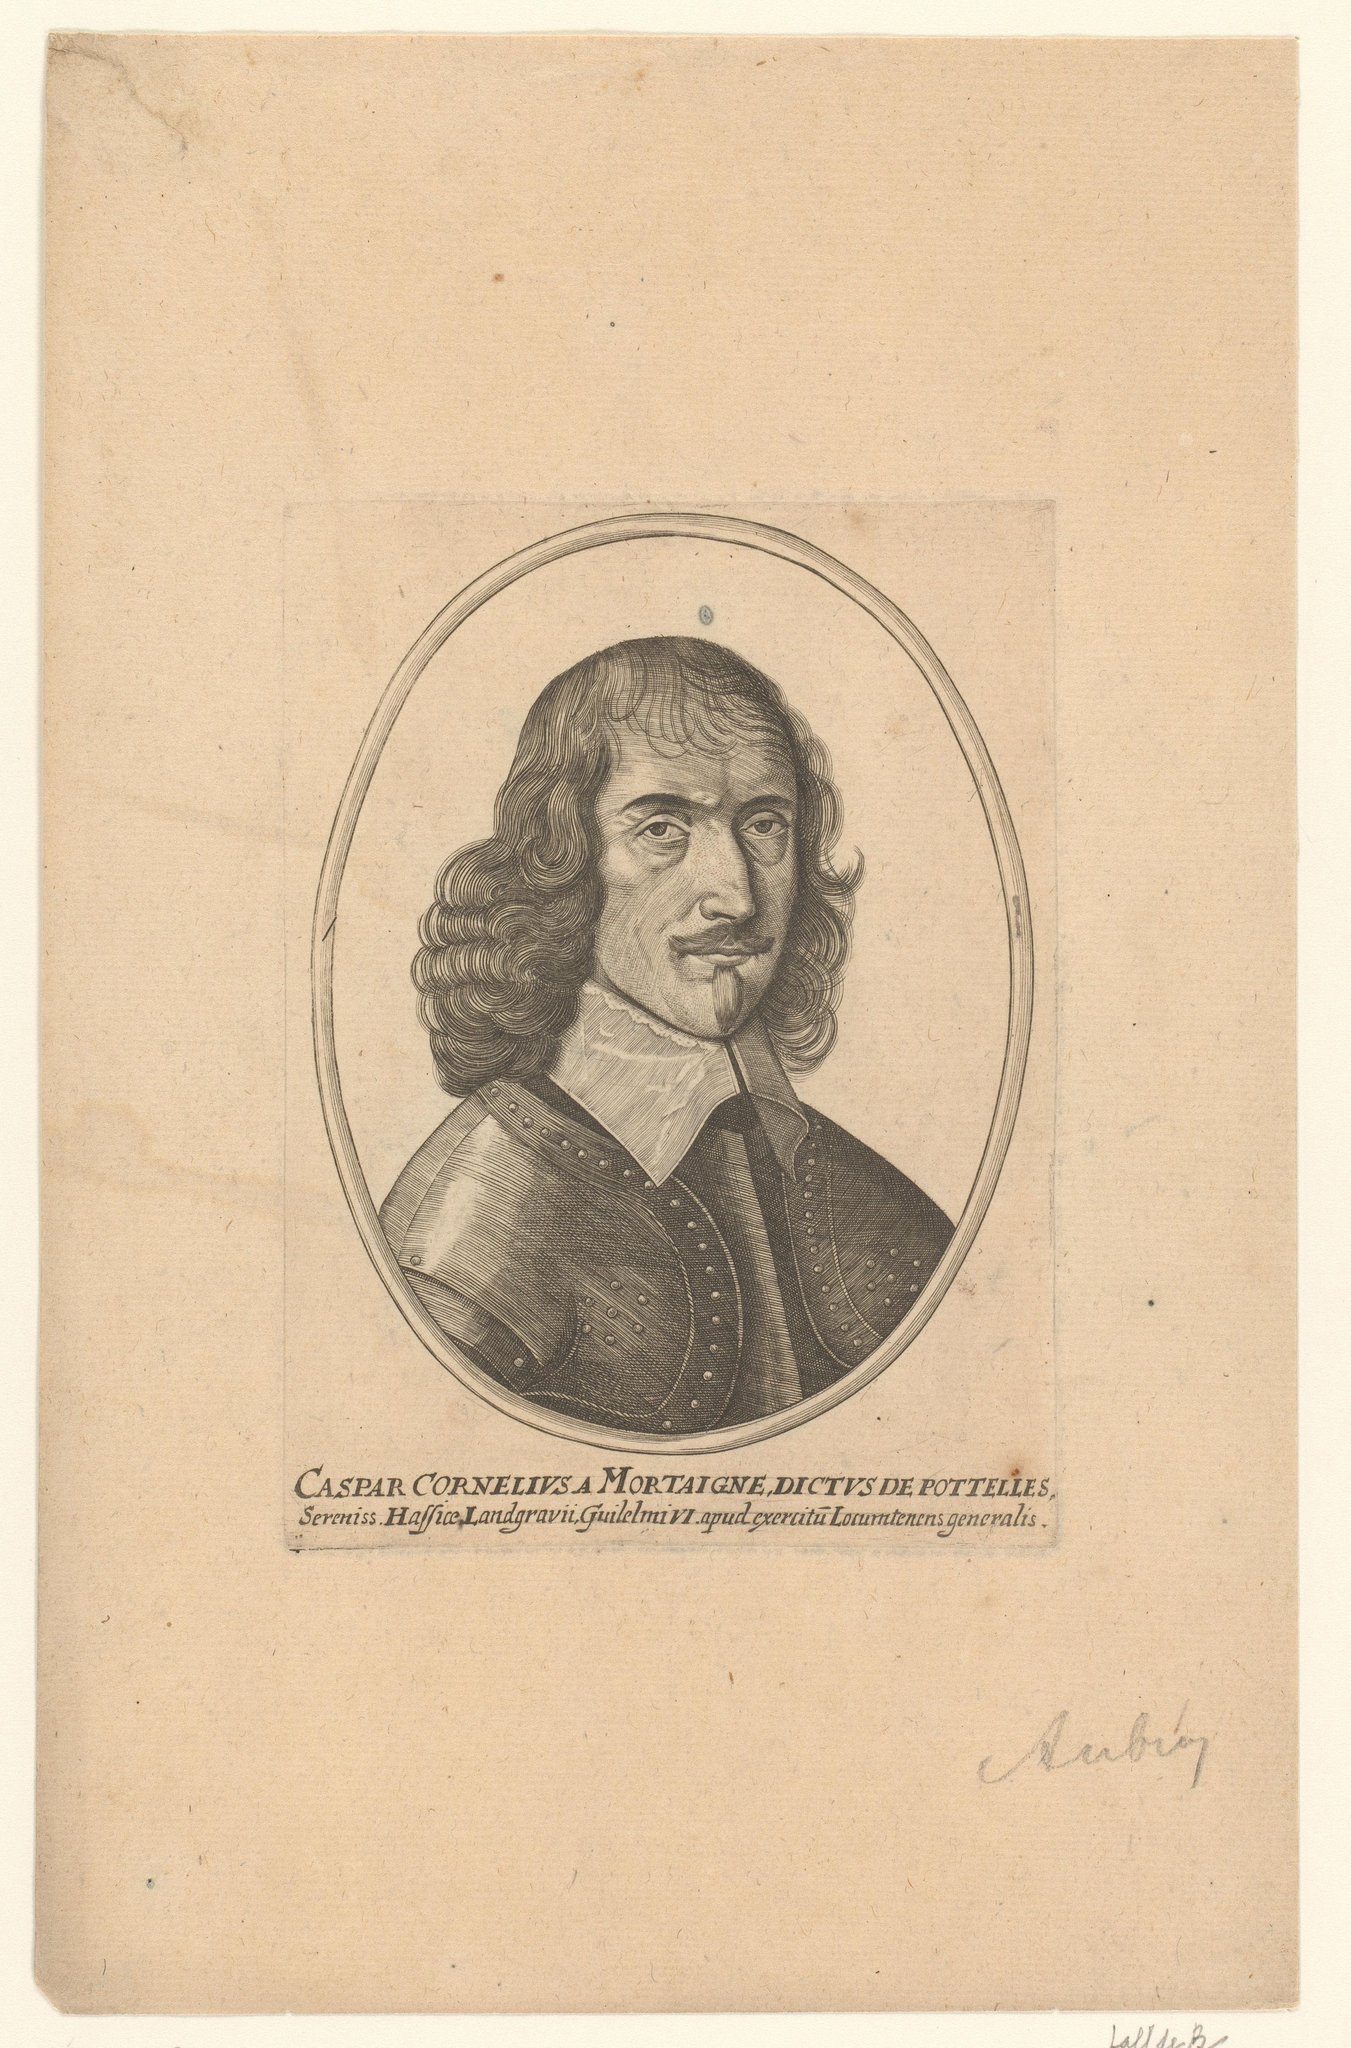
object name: print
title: Portret van Kaspar Kornelius Mortaigne de Potelles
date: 1646-1686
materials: paper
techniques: engraving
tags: commander-in-chief, general, marshal, historical persons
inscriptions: collector's mark: Lugt 2228